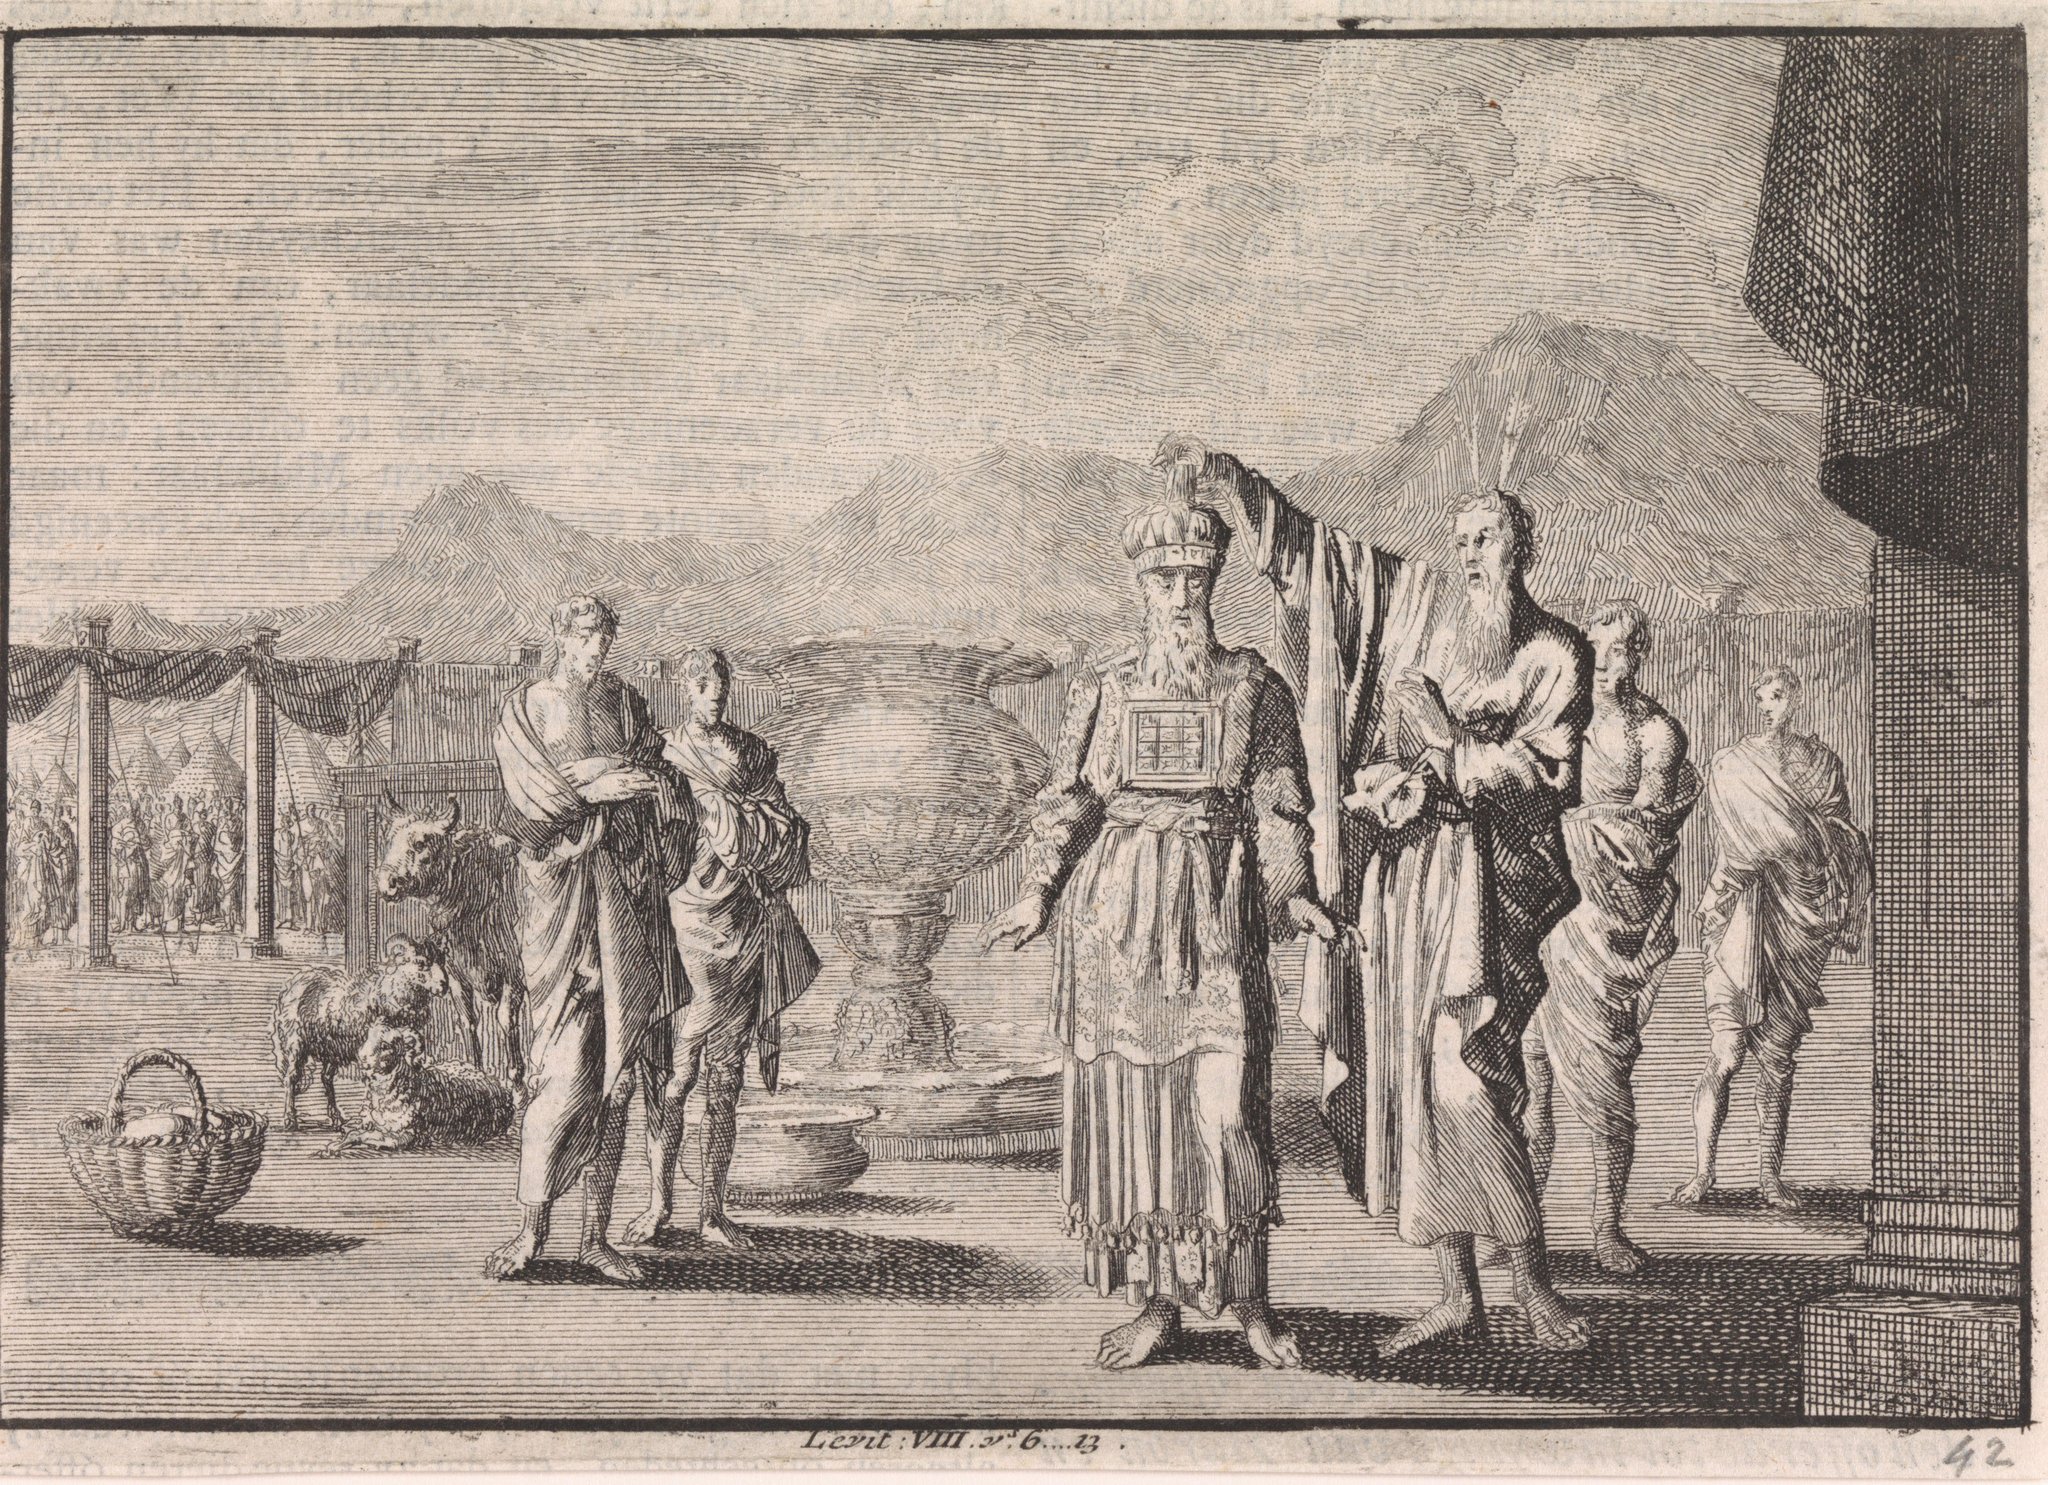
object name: book illustration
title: Aäron en zijn vier zonen als priester gewijd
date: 1703-1762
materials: paper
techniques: etching, letterpress printing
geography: amsterdam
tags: aaron and his four sons are ordained by moses (leviticus 8)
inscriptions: collector's mark: Lugt 2228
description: De prent komt een eerste keer voor als boekillustratie voor David Martin. Historie des Ouden en Nieuwen Testaments. Amsterdam, Pieter Mortier, 1703. Deel I. De boekillustraties voor de Mortierbijbel hebben verschillende staten en kopieën, waarbij de chronologische volgorde moeilijk te achterhalen valt. Als boekillustraties werden ze bovendien herhaaldelijk opnieuw gebruikt voor andere boekwerken.